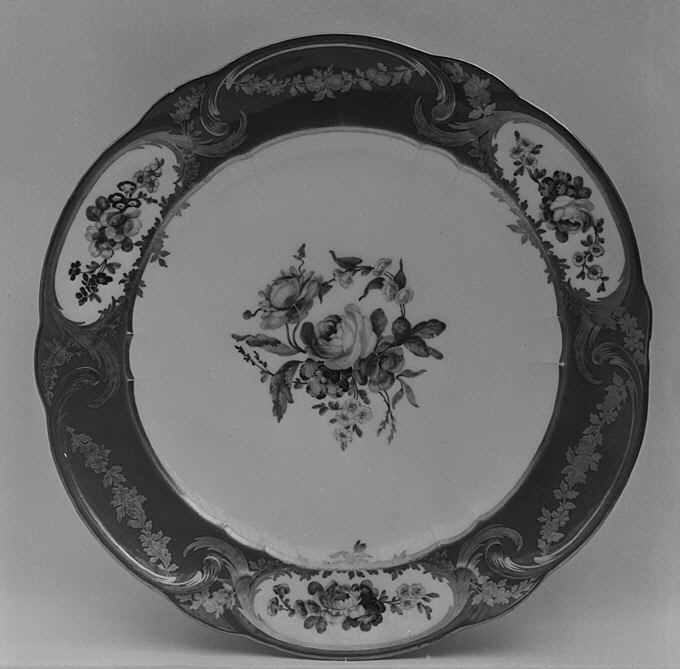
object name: plate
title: Plate (assiette à palmes) (1 of 102) (part of a service)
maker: sèvres manufactory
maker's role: manufactory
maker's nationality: french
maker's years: 1740-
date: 1772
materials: soft paste porcelain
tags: flowers